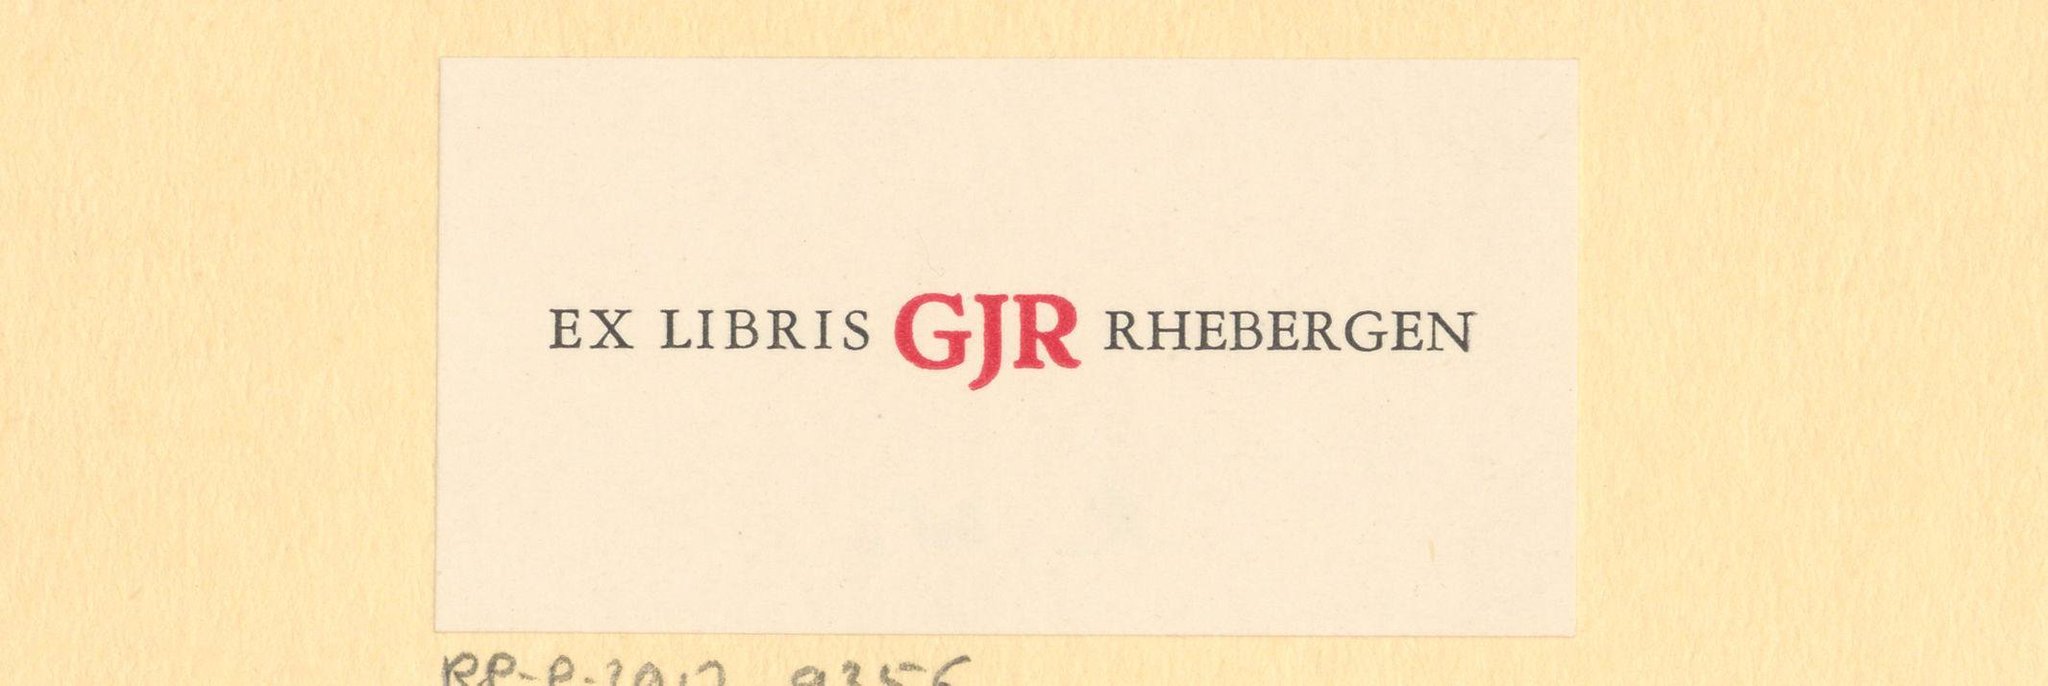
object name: bookplate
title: Ex libris G.J.R. Rhebergen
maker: Anonymous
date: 1925-2002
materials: paper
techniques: printing block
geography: netherlands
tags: gerrit jan rhebergen (jan)